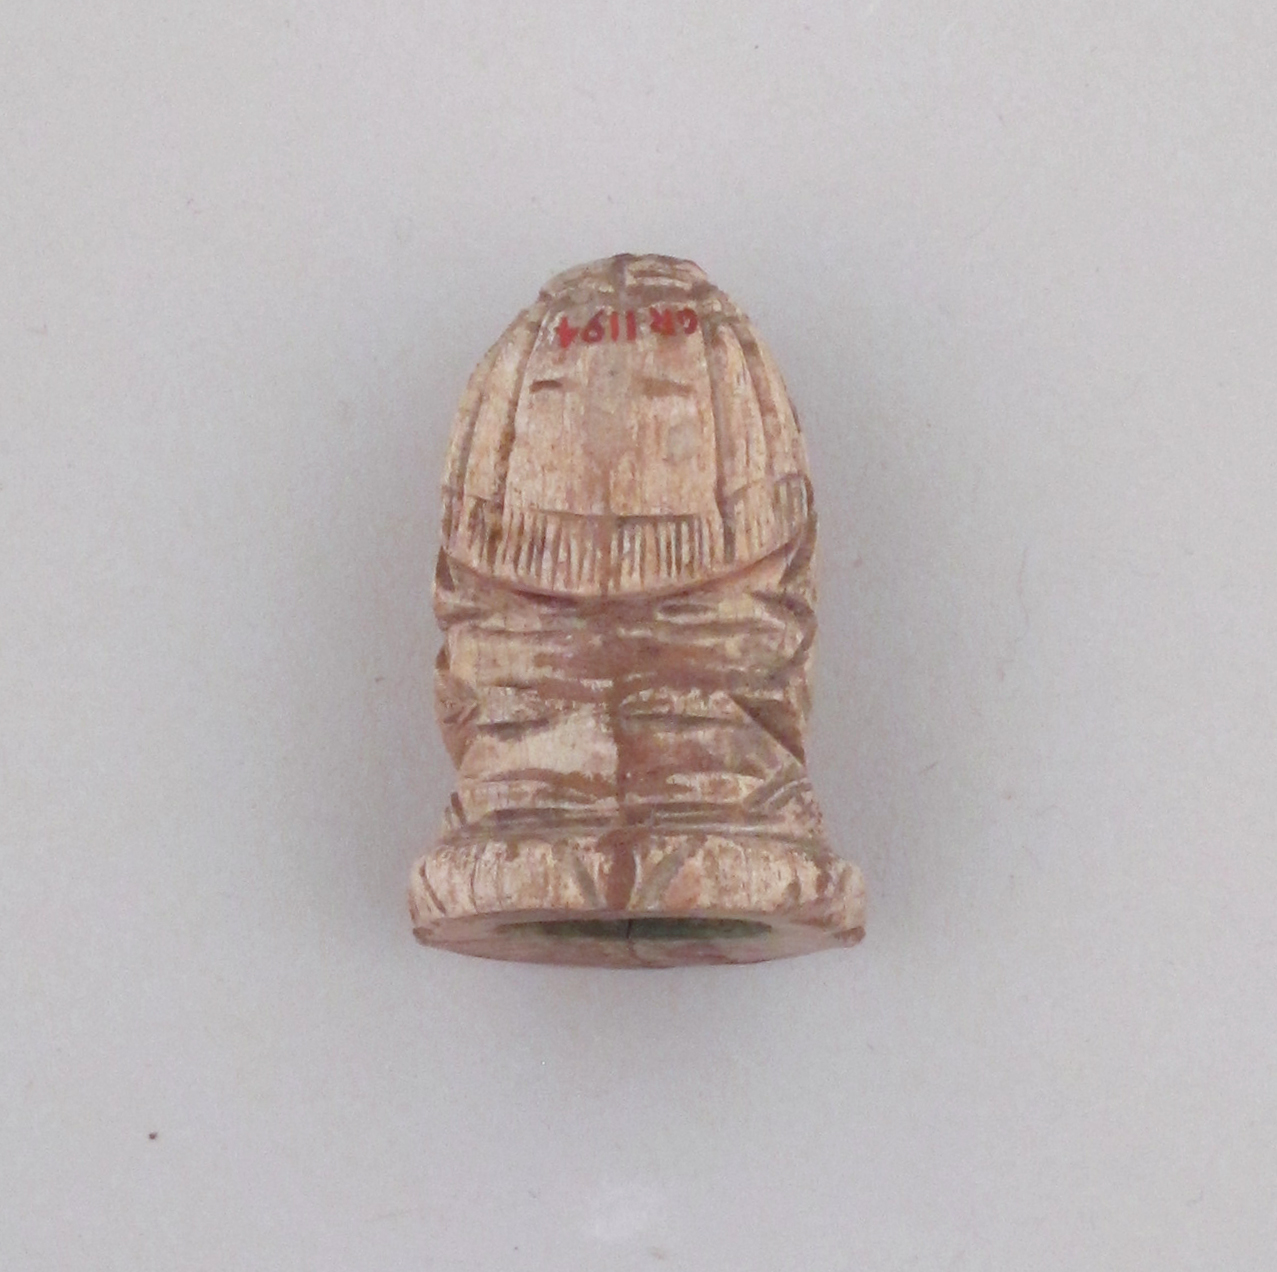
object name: finial or handle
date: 7000 BCE-330 CE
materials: bone